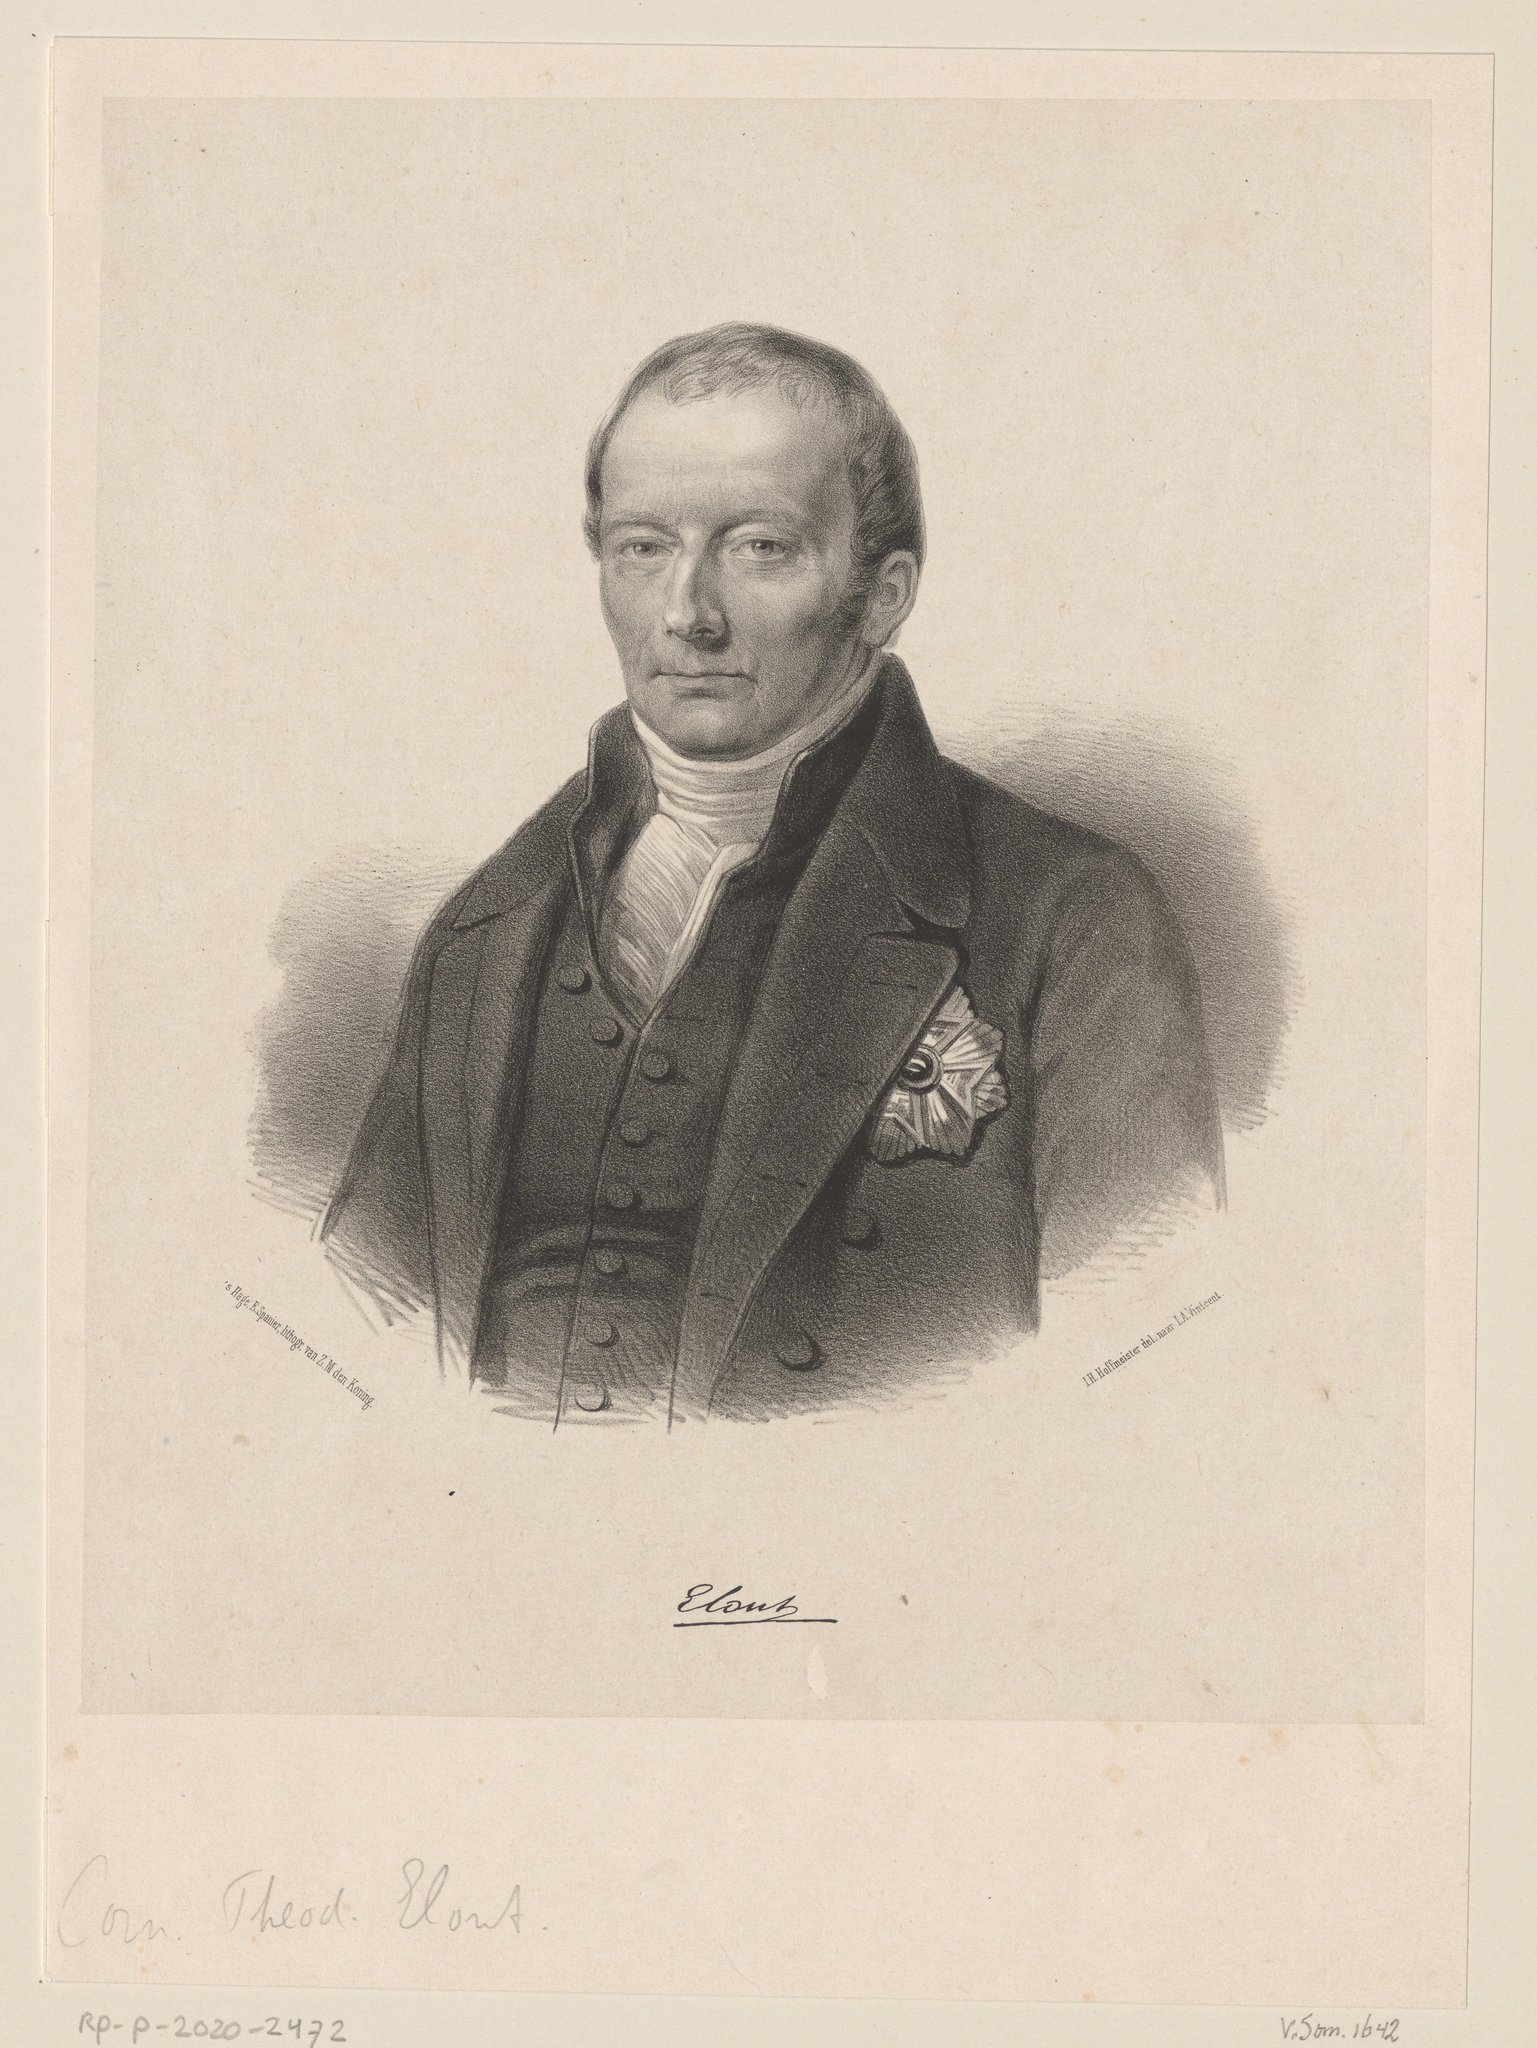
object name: print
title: Portret van Cornelis Theodorus Elout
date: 1851-1863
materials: paper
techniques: lithograph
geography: the hague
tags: haarlem, the hague, historical persons, politician, e.g. party leader